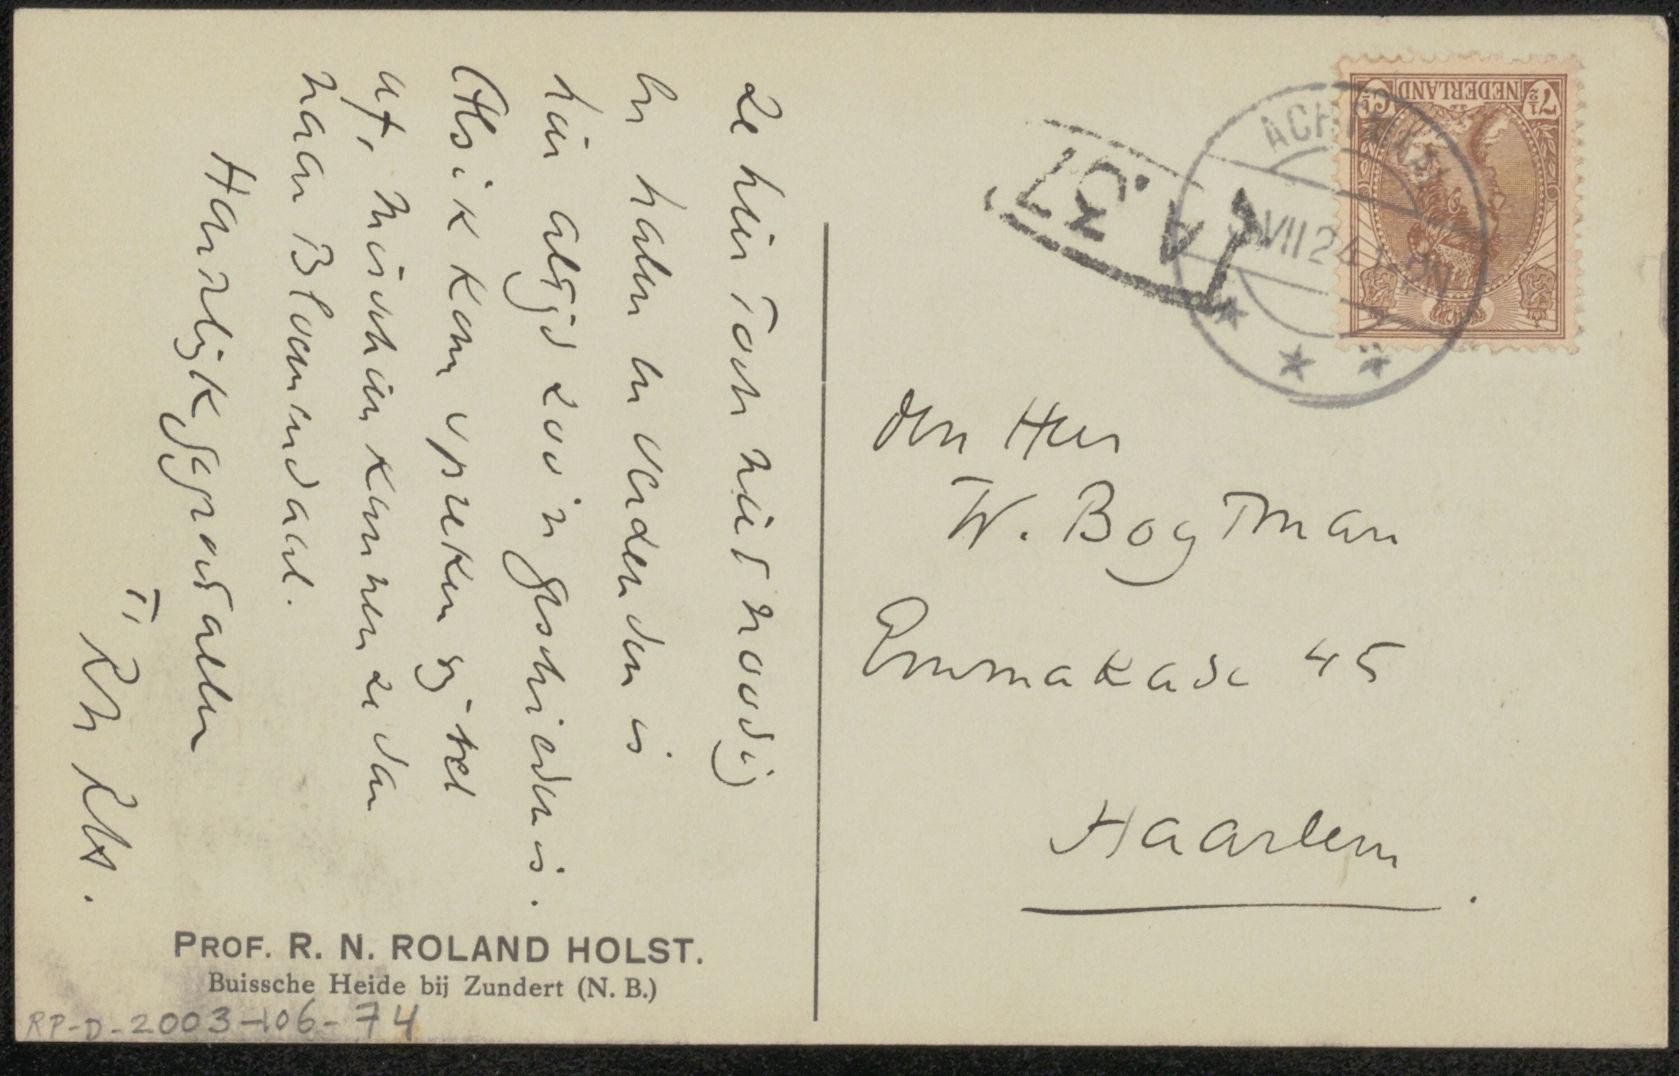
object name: postcard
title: Briefkaart aan Willem Bogtman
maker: richard nicolaüs roland holst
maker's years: 1868-1938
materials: cardboard, ink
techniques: pen, writing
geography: achtmaal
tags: haarlem, willem bogtman, applied arts, arts and crafts; industrial design, family life, painting (including book-illumination, miniature-painting), money